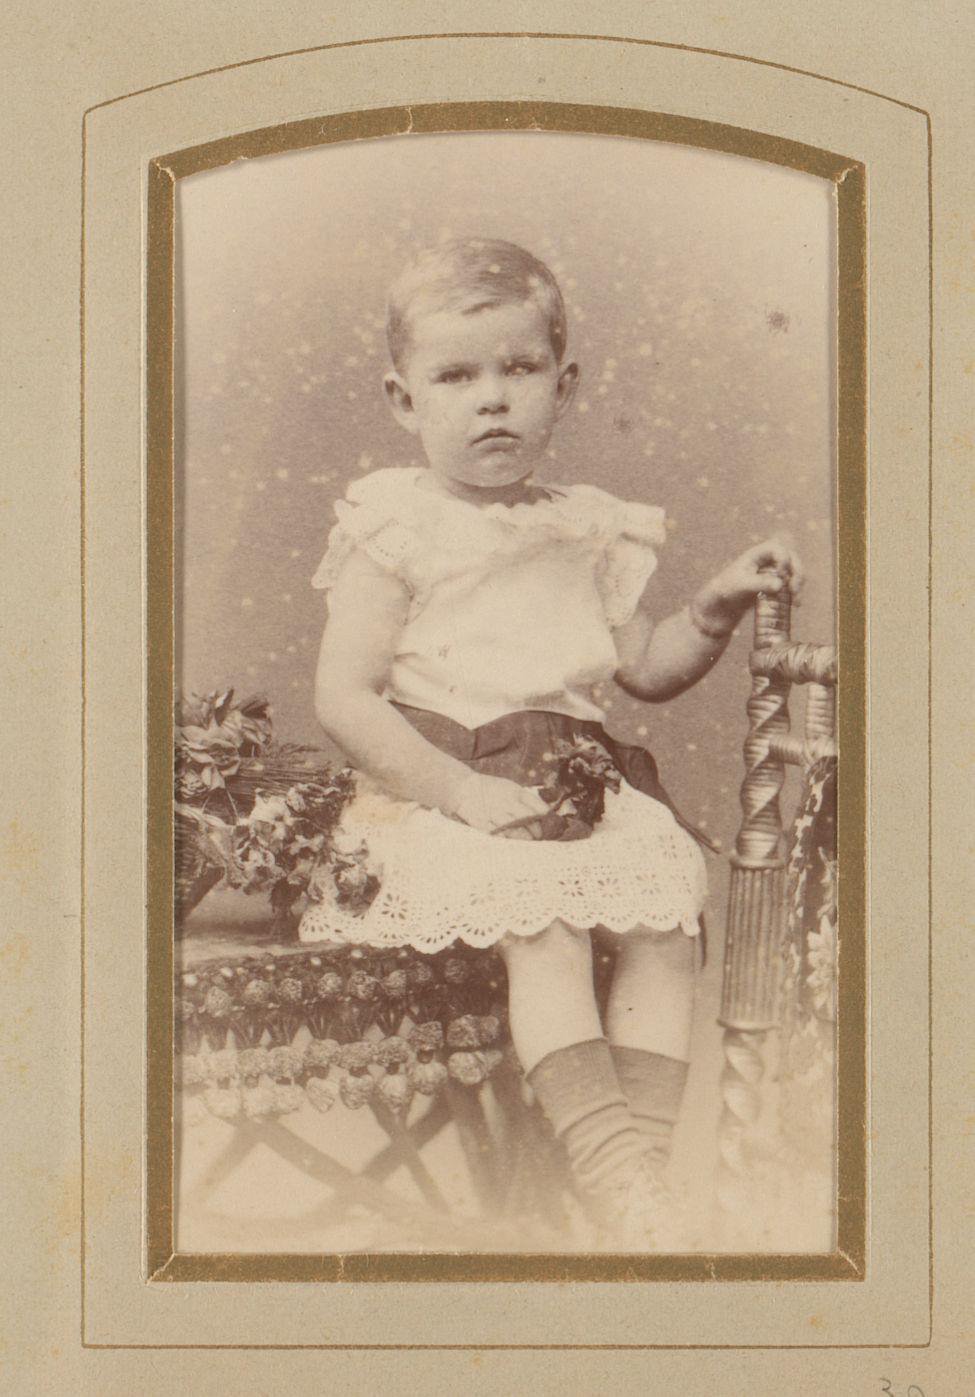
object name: carte de visite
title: Studioportret van Margo Kessler op jeugdige leeftijd in een wit jurkje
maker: kameke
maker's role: painter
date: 1886-1889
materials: paper, photographic support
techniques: photography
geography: amsterdam